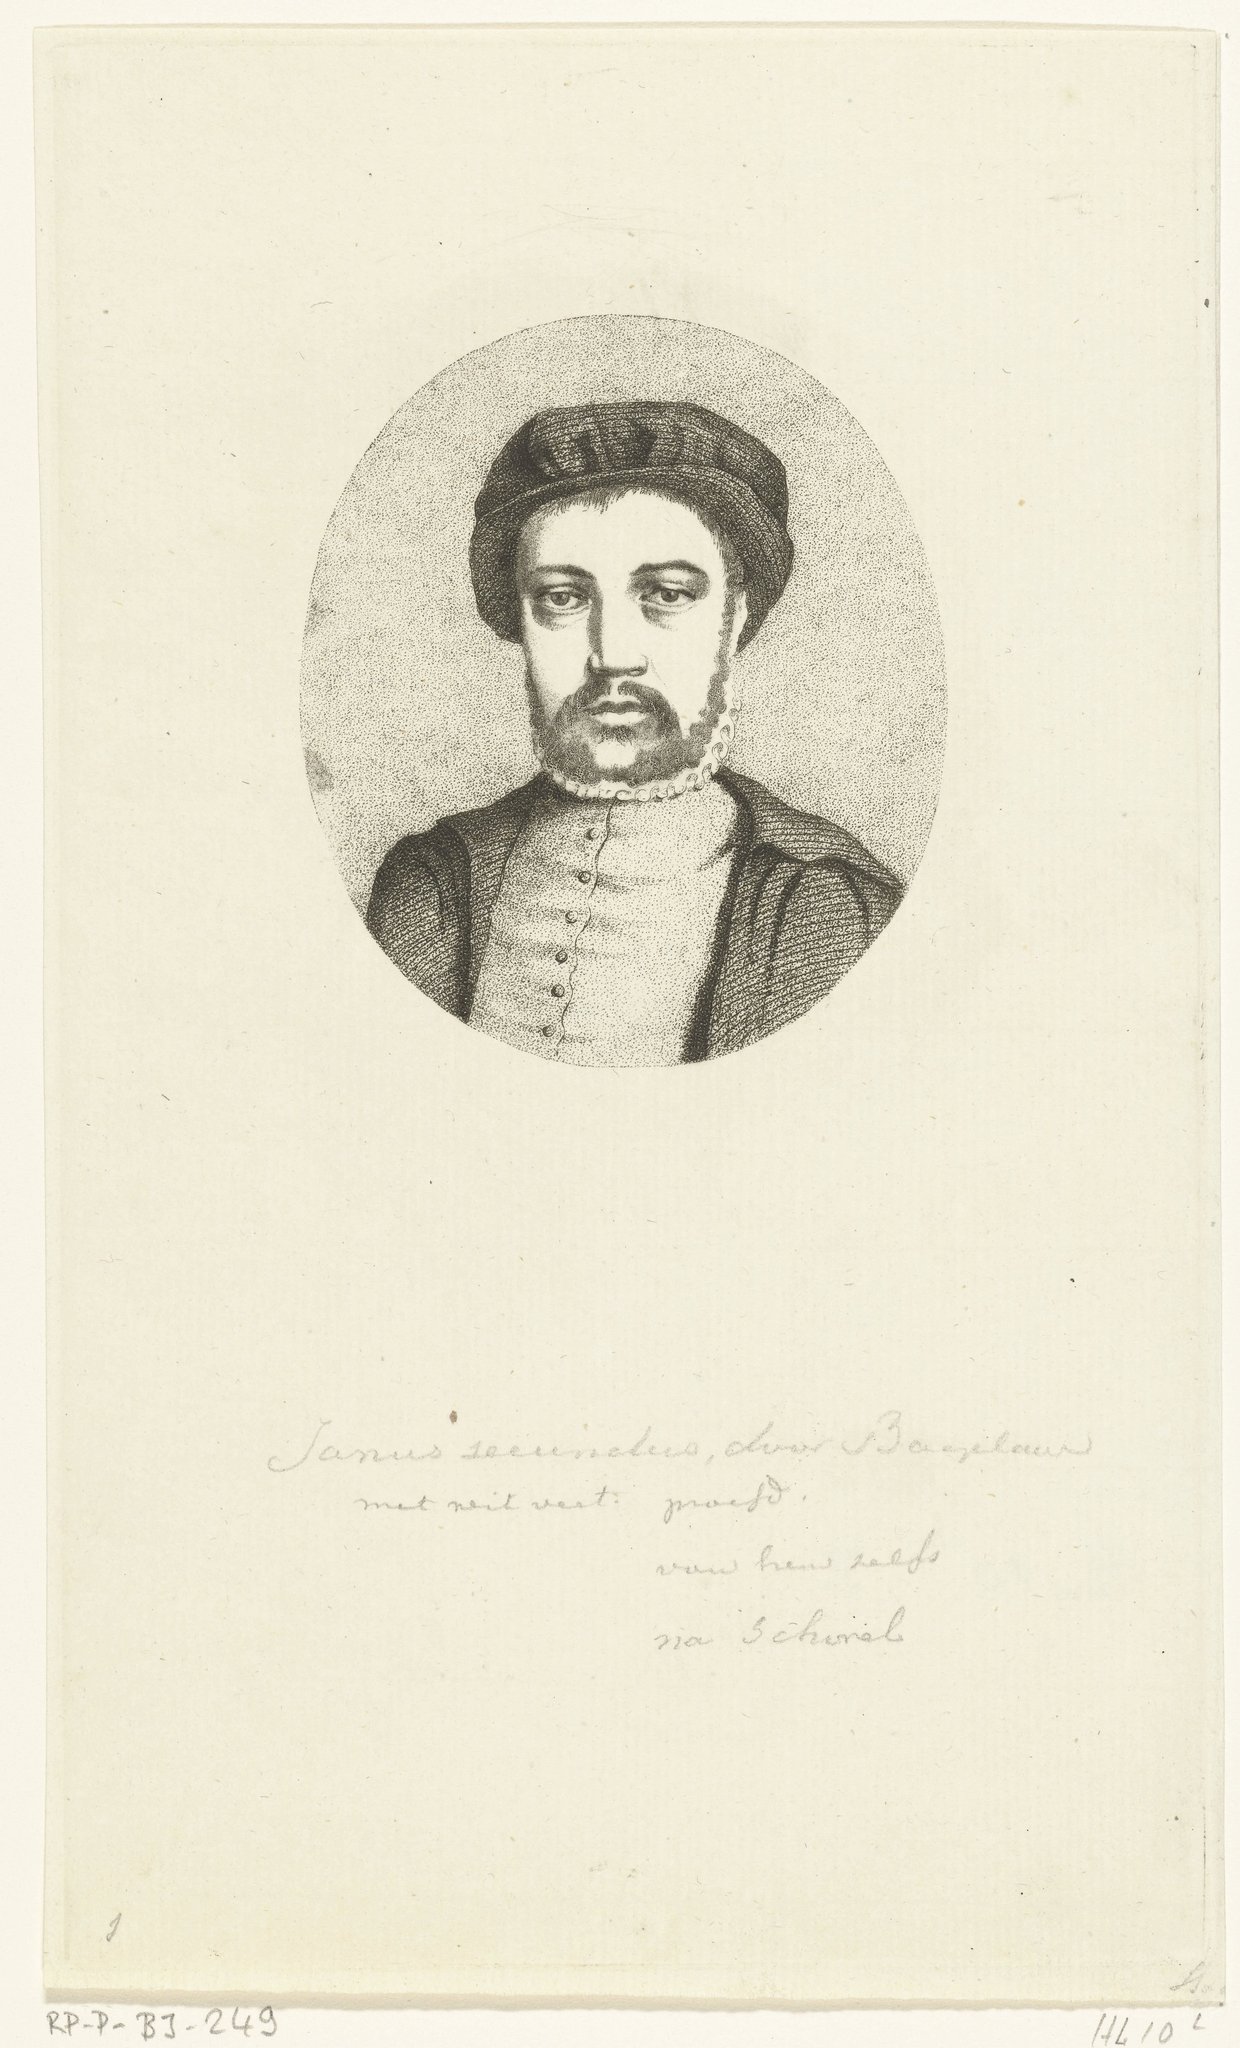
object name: print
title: Portret van Janus Secundus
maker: ernst willem jan bagelaar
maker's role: draughtsman, print maker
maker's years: 1775-1837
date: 1798-1837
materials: paper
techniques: aquatint, etching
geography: netherlands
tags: the hague, janus secundus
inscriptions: collector's mark: Lugt 2228